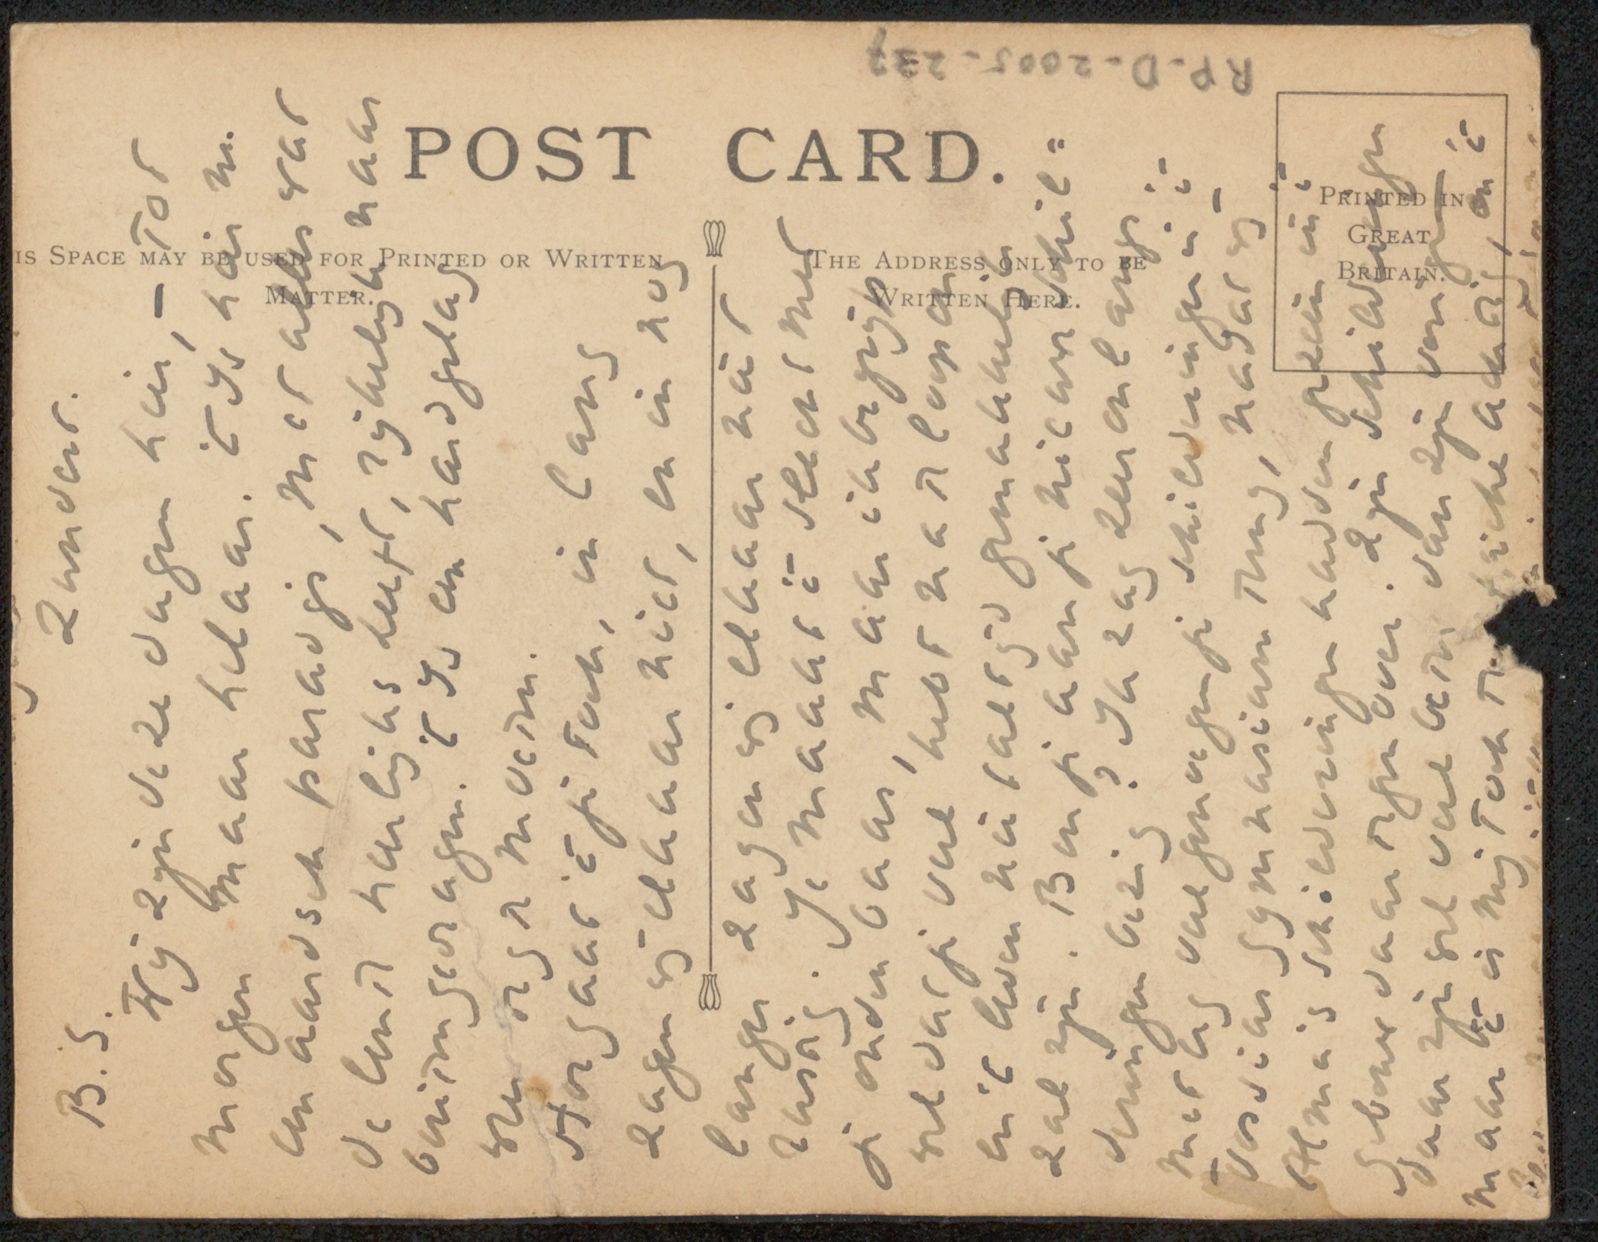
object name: ansichtkaart, prentbriefkaart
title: Prentbriefkaart aan Joop Sjollema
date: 1910-1938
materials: cardboard, ink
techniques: pen, printing, writing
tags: print maker, draughtsman, joop sjollema, painting (including book-illumination, miniature-painting)